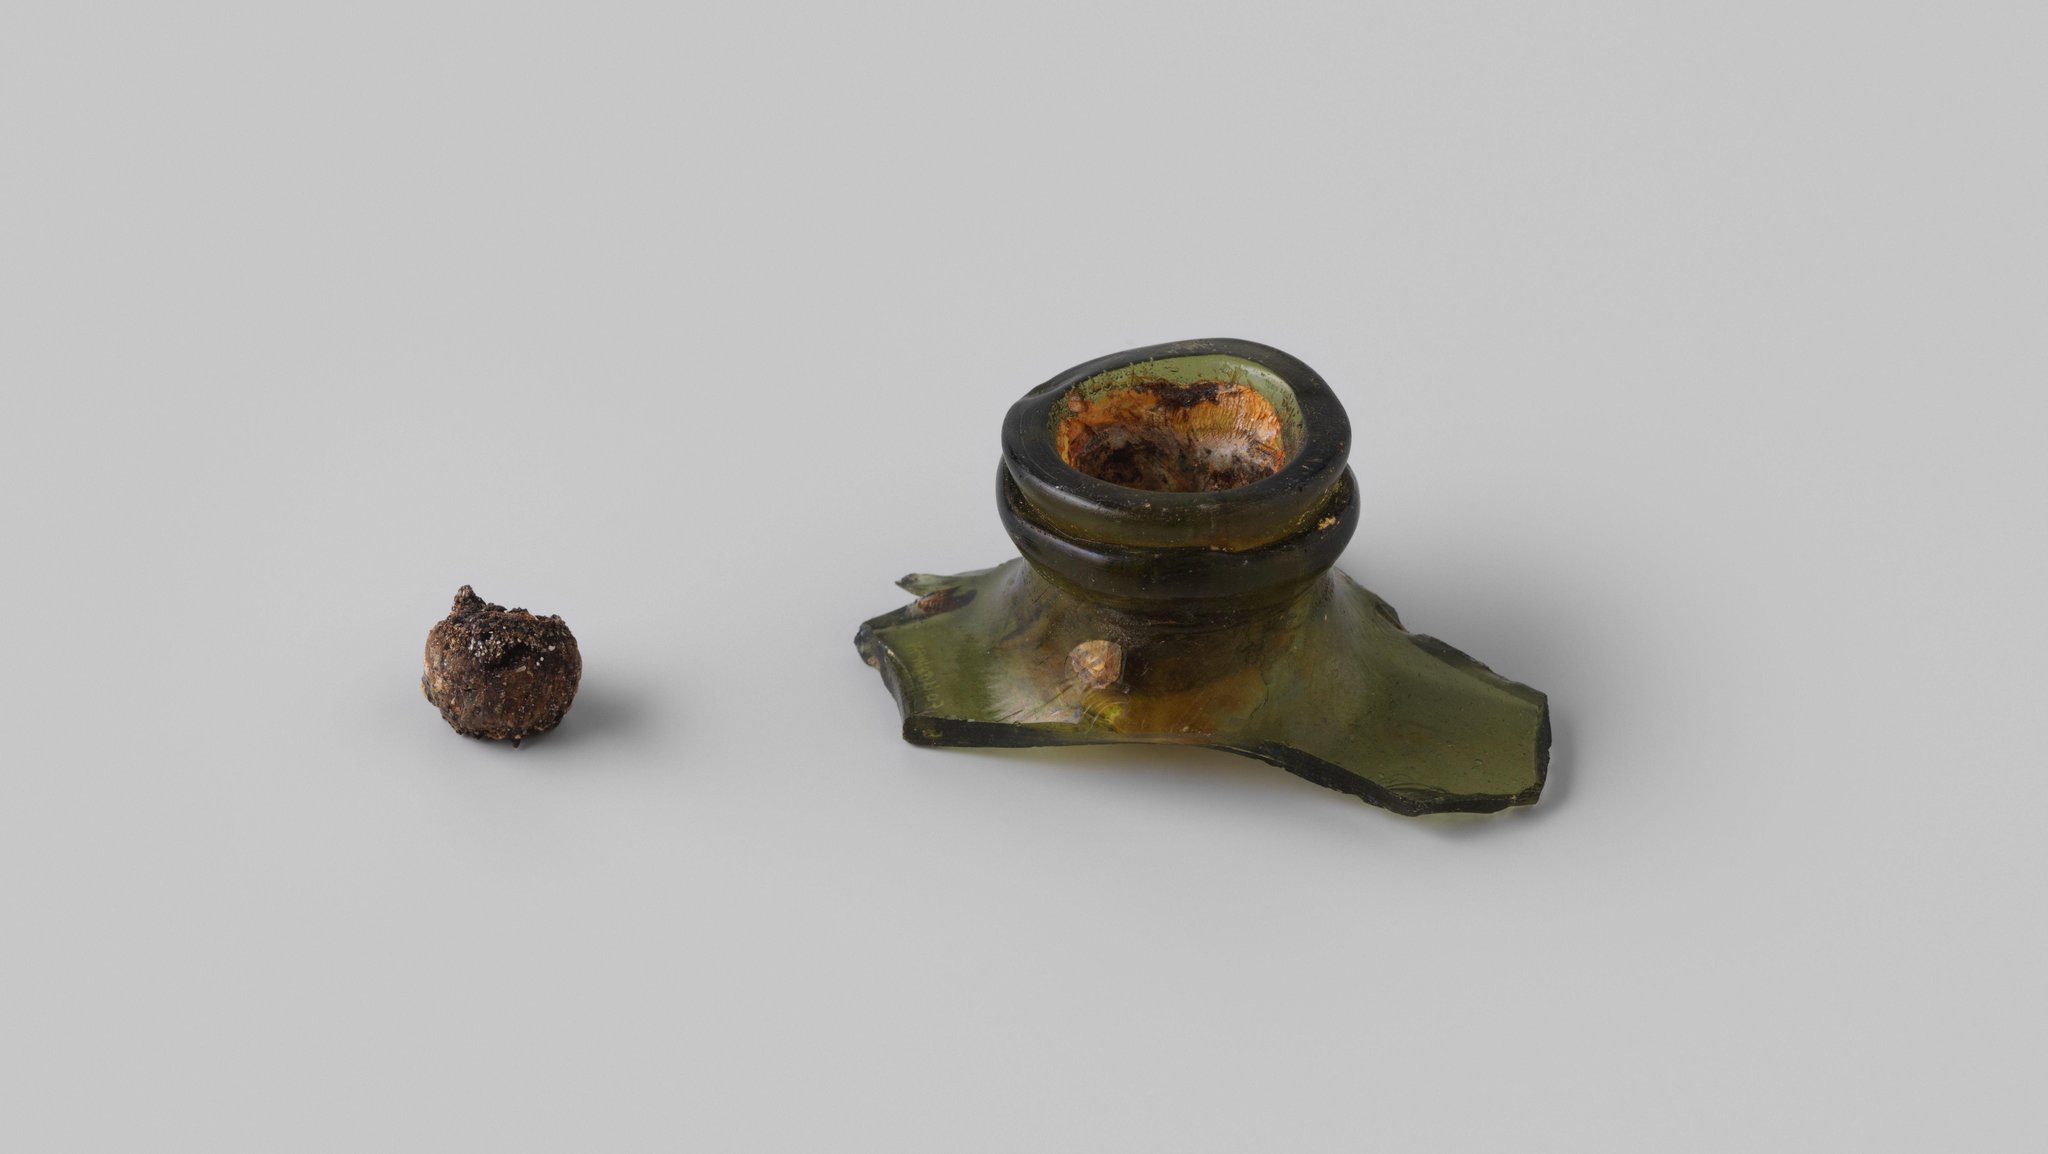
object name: sherd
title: Halsfragment kelderfles met kurk uit het wrak van de Oost-Indiëvaarder Hollandia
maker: Anonymous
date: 1700-1743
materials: cork, glass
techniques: green glass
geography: netherlands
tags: verenigde oostindische compagnie, hollandia (schip), annet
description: Case bottle, fragm, neck, circular everted mouth, flattened vs-string rim.